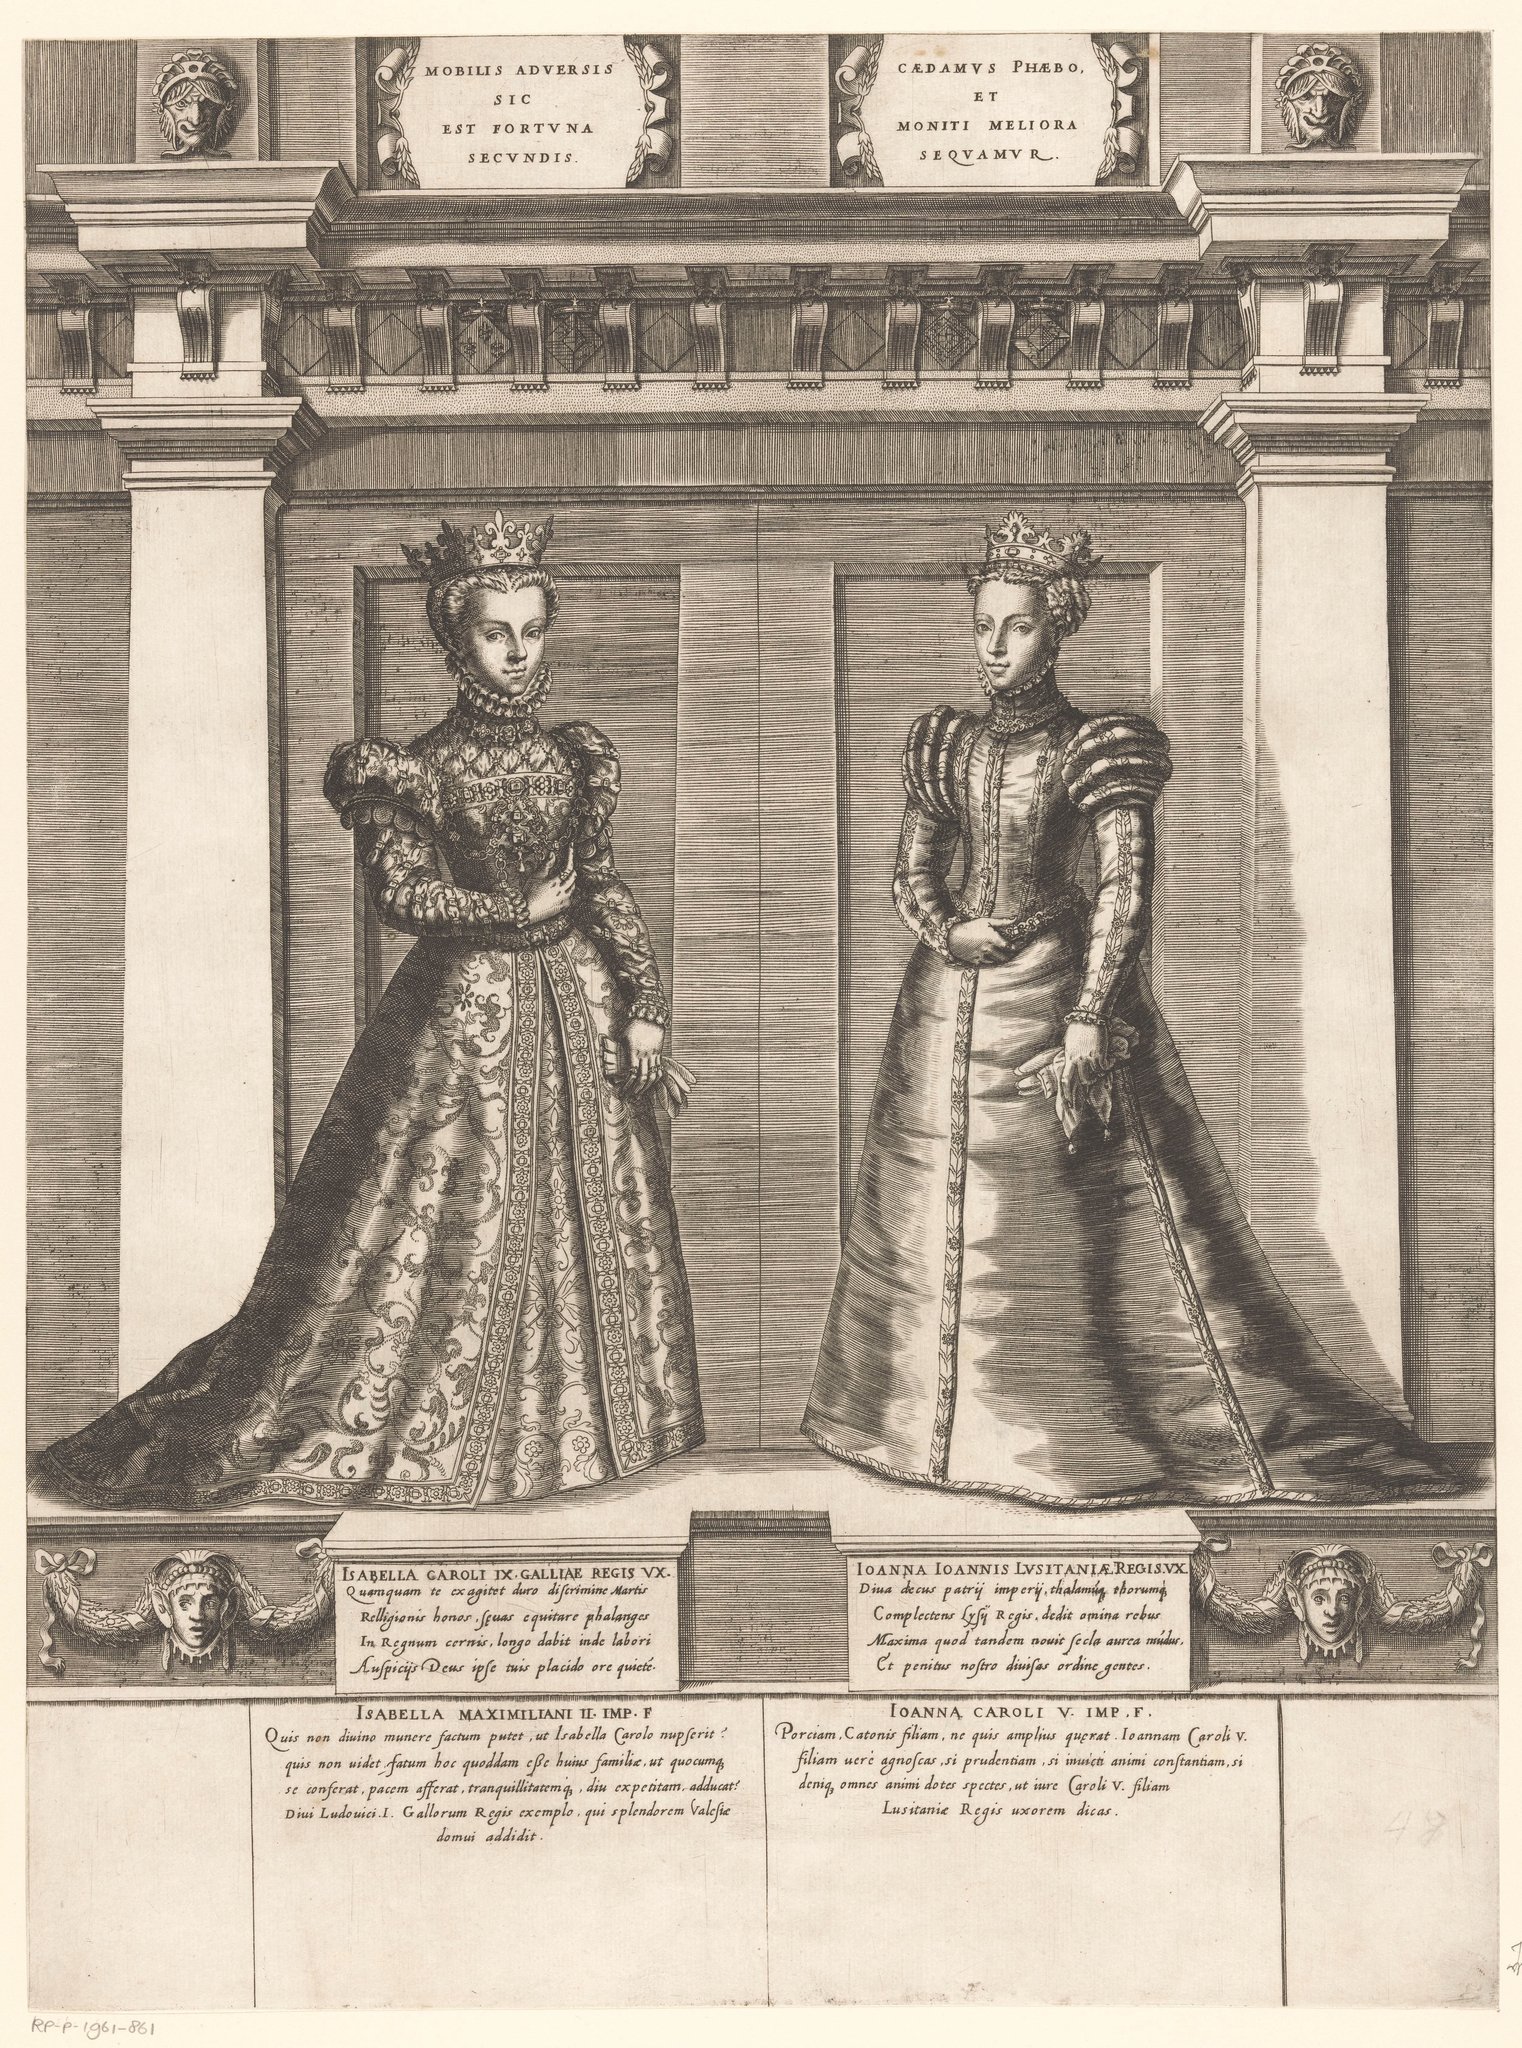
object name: print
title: Portretten van leden van het Oostenrijkse Huis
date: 1569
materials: paper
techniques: engraving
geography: italy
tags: historical persons - bb - woman, ruler, sovereign - bb - female ruler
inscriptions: collector's mark: Lugt 2228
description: Deze prent maakt deel uit van een reeks van 58 prenten. Het meerendeel van de prenten bevat portretten van 74 leden van het Oostenrijkse Huis, naar tekeningen door Francesco Terzio, die deels getekend zijn naar de 28 levensgrote bronzen beelden die rond de cenotaaf van Maximiliaan I in de Hofkirche te Innsbruck staan.